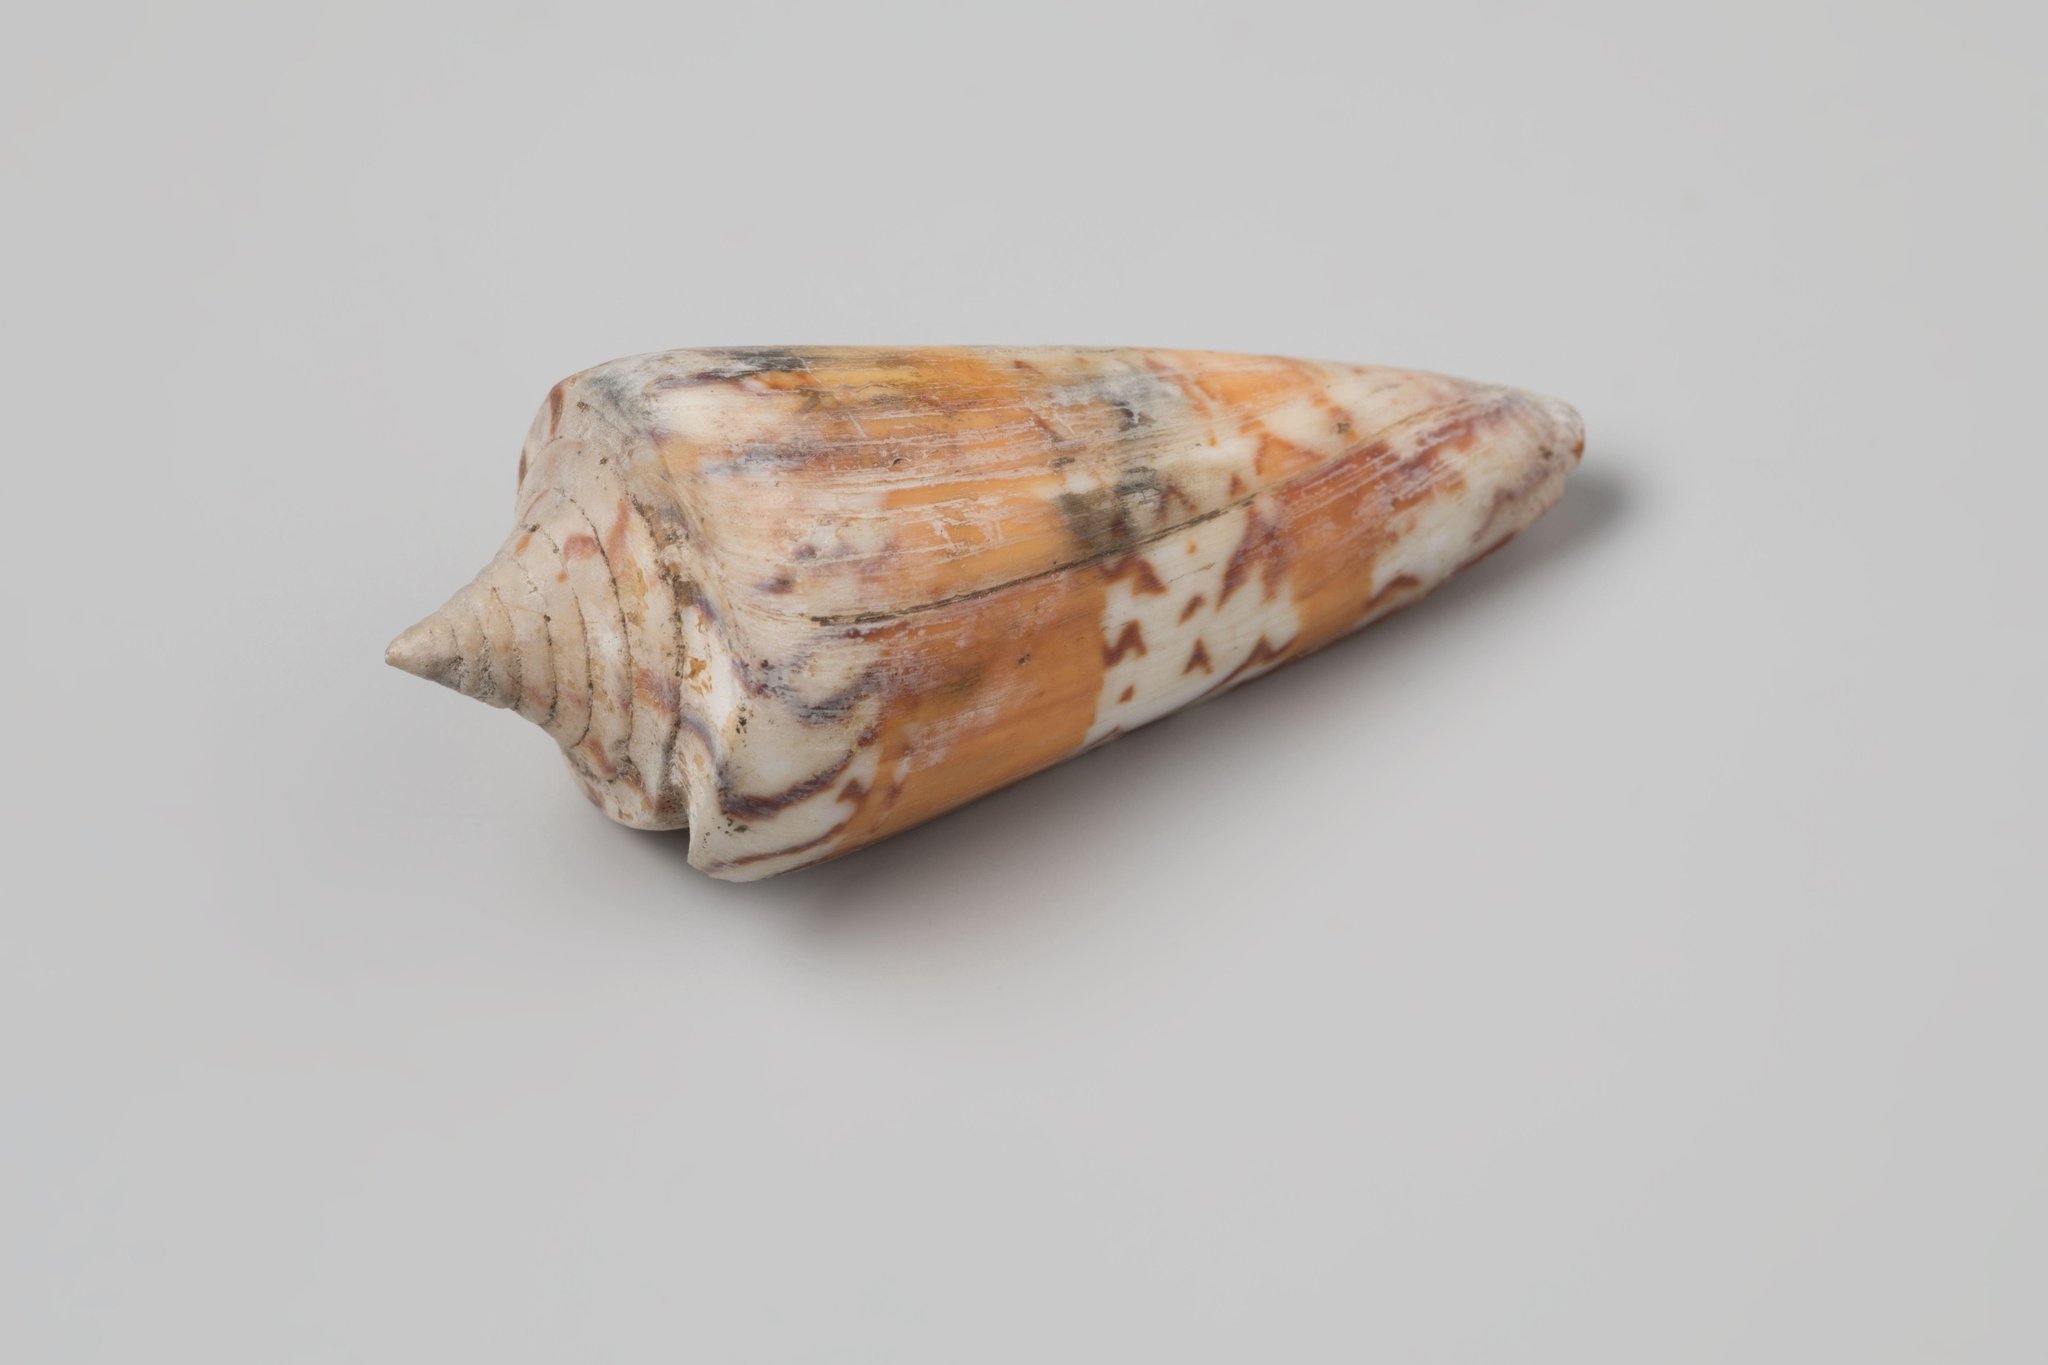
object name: conus generalis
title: Conus generalis shell from the wreck of the Dutch East India ship Witte Leeuw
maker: niet van toepassing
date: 1613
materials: shell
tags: verenigde oostindische compagnie, sint-helena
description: Schelp uit V.O.C.-schip de 'Witte Leeuw'.